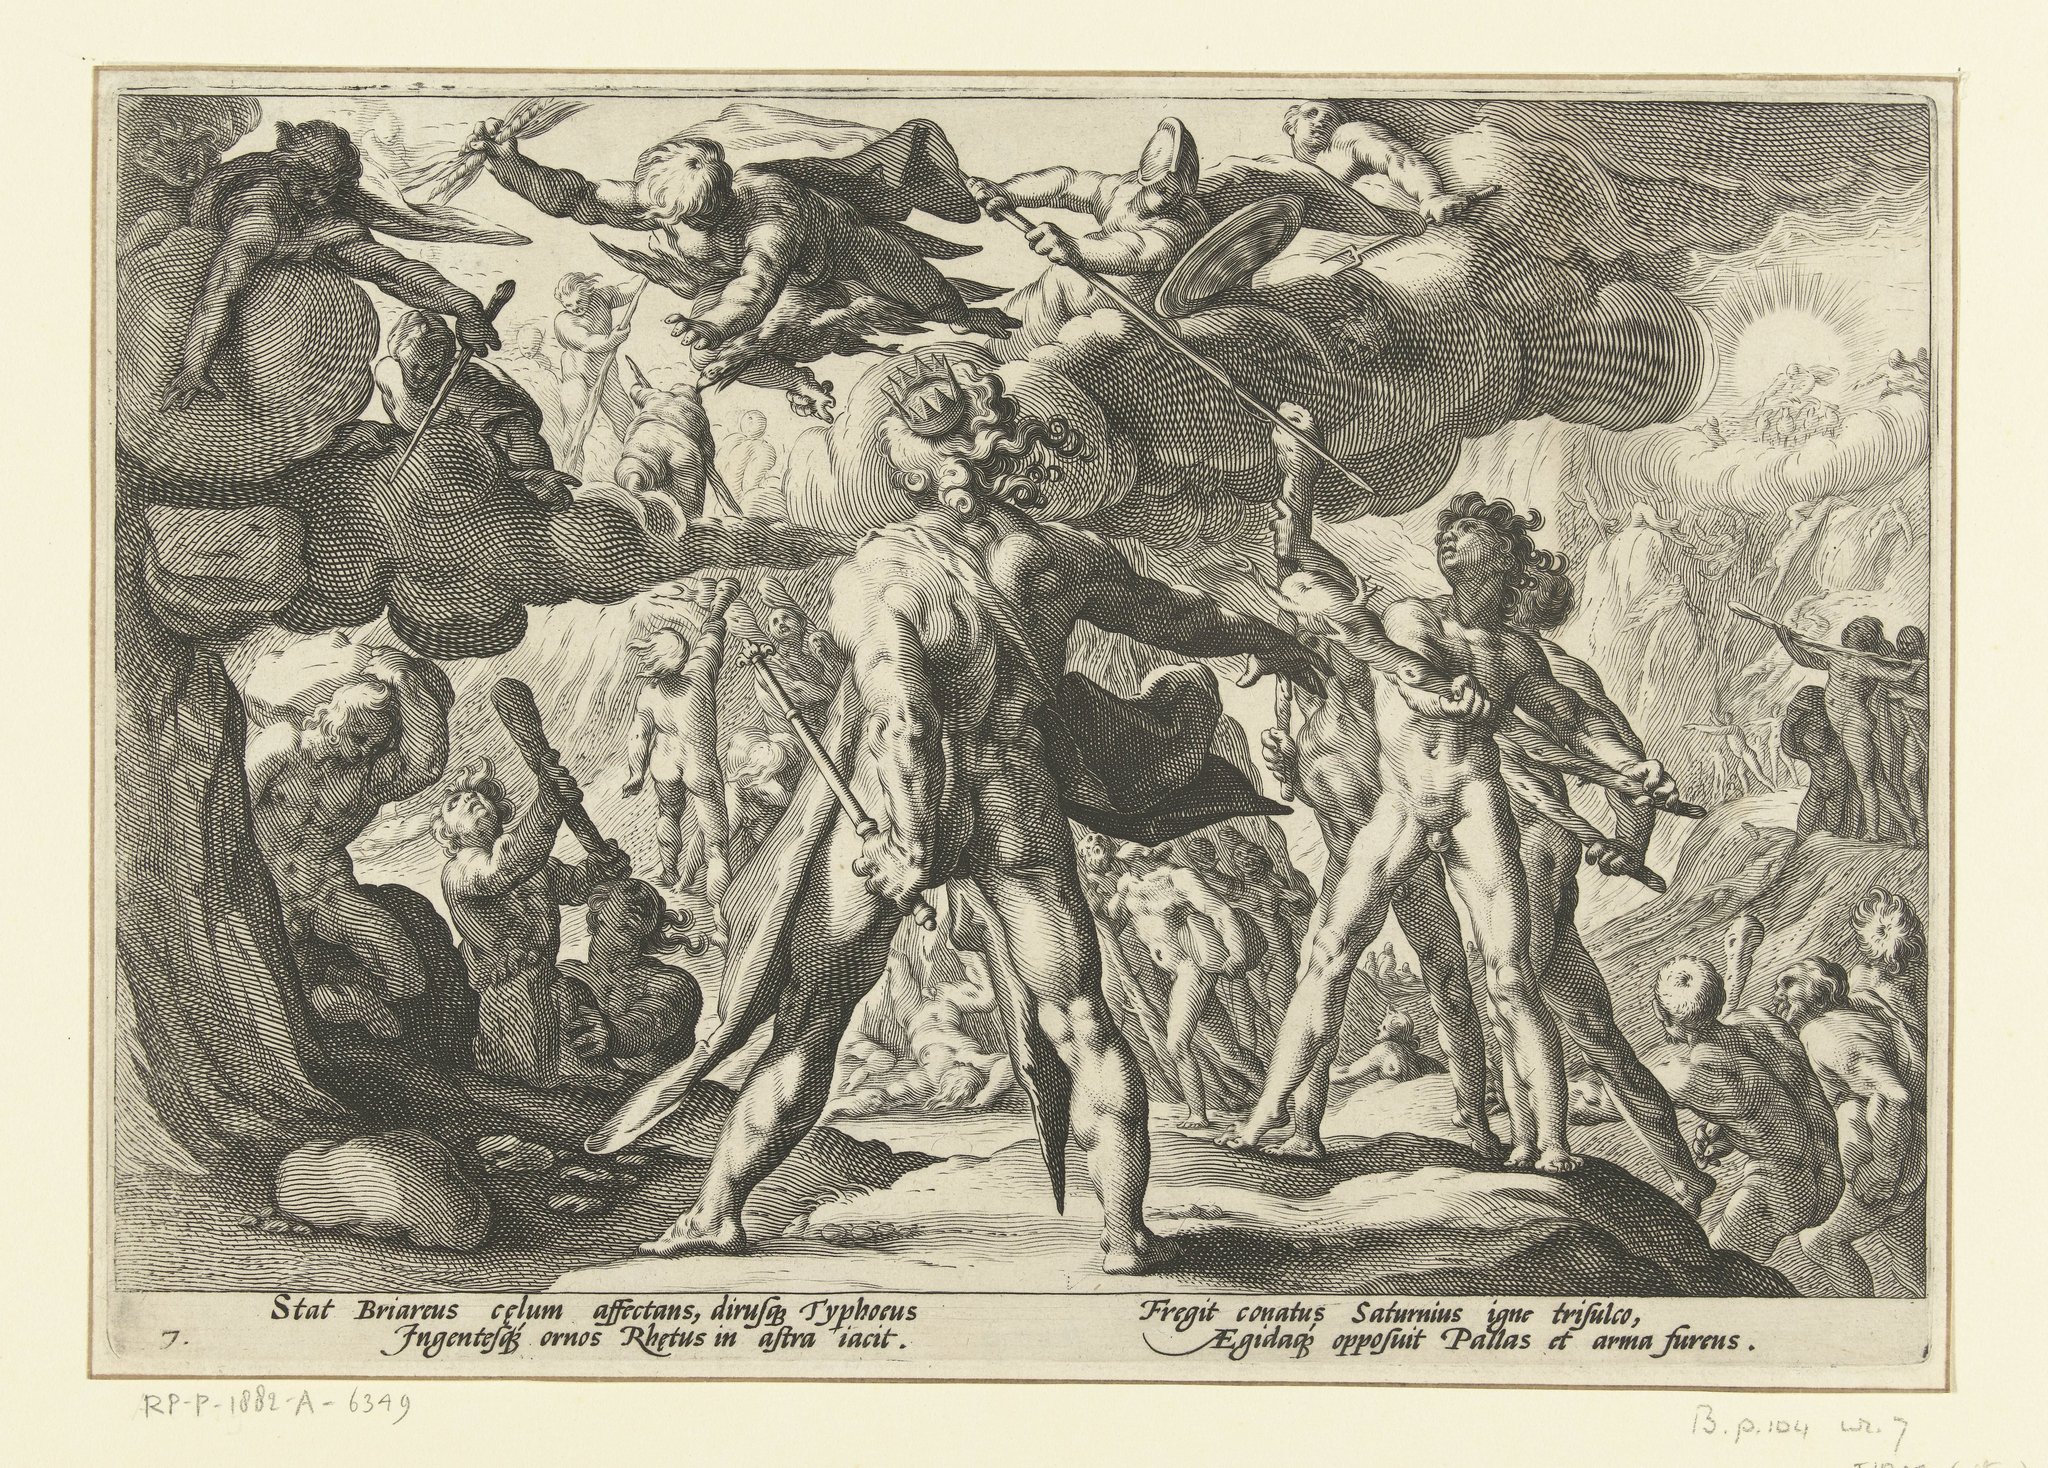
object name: print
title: Ovidius' Metamorfosen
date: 1589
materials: paper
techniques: engraving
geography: haarlem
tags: the giants attack the heavens with boulders and tree-trunks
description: De Giganten proberen vanaf de aarde via bergen en met knotsen de hemel te veroveren waar de Olympische goden huizen. Laatstgenoemde vechten met wapens zoals speer, bliksem en drietand terug. Onder de voorstelling twee keer twee regels Latijnse tekst. Deze prent is onderdeel van een serie van 52 prenten die verhalen uit Ovidius' Metamorfosen verbeelden. Deze serie valt uiteen in drie genummerde reeksen: twee van 20 prenten en één van 12 prenten. Deze prent behoort tot de eerste reeks.